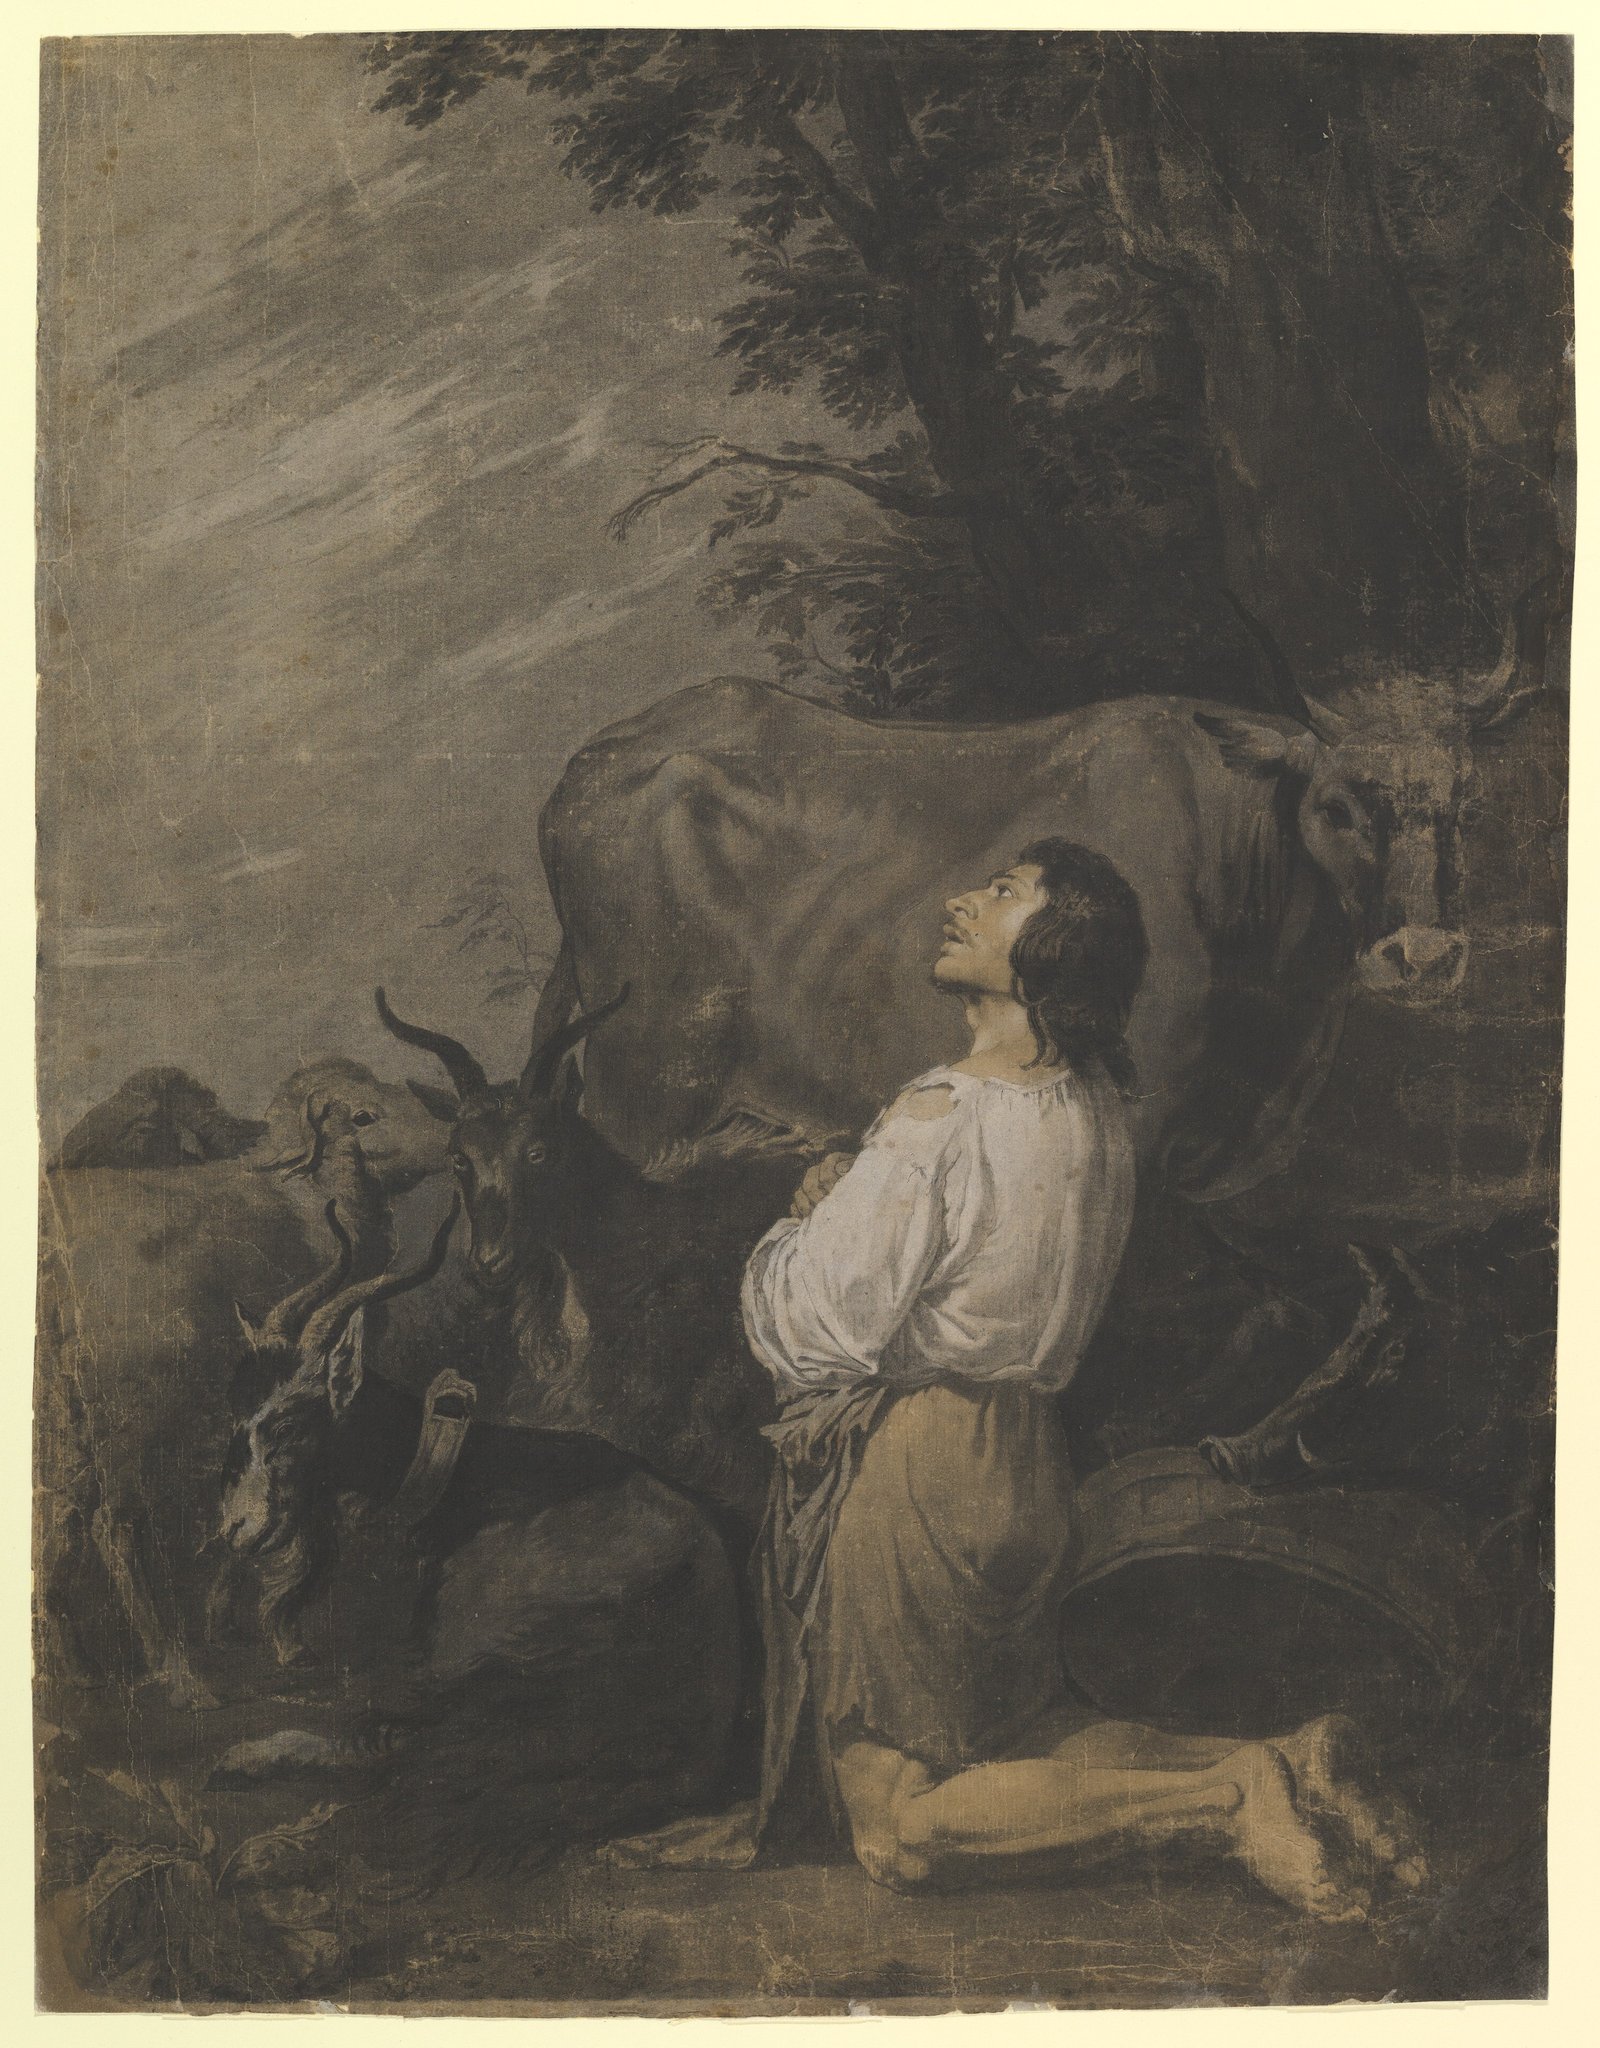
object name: drawing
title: The Prodigal Son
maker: salvator rosa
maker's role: artist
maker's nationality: italian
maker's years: 1615-1673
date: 1615-1673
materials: chalk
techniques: wash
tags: men,cows,goats